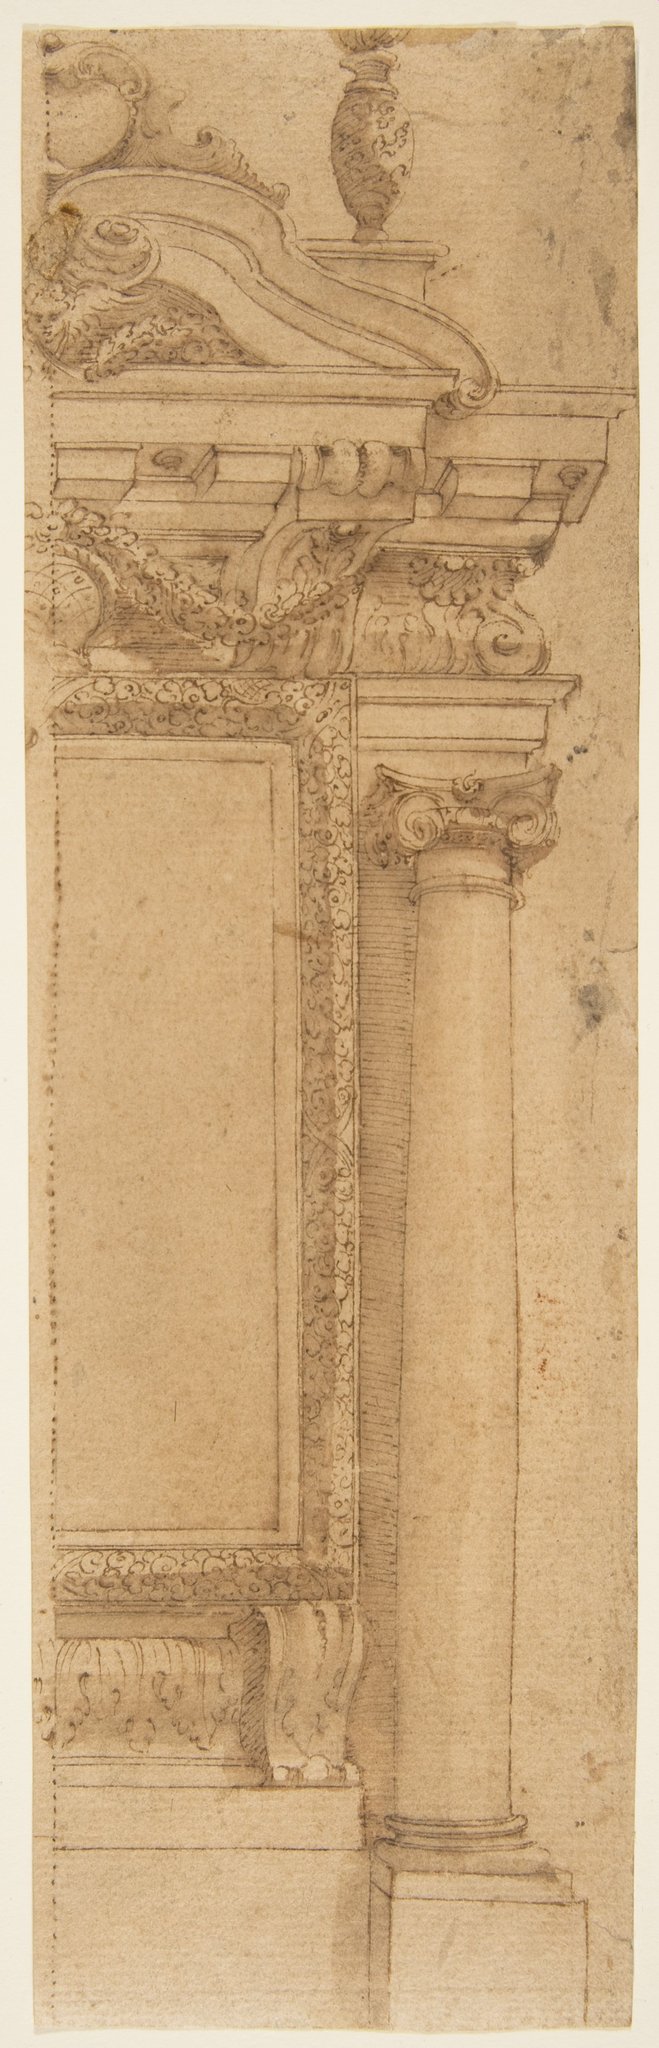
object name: drawing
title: Architectural Design Presenting Two Alternate Solutions (in two fragments)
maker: anonymous, italian, 17th century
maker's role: artist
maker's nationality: italian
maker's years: 1600-1700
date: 1601-1700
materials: ink, drawing material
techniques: brush, pen, wash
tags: architecture,columns